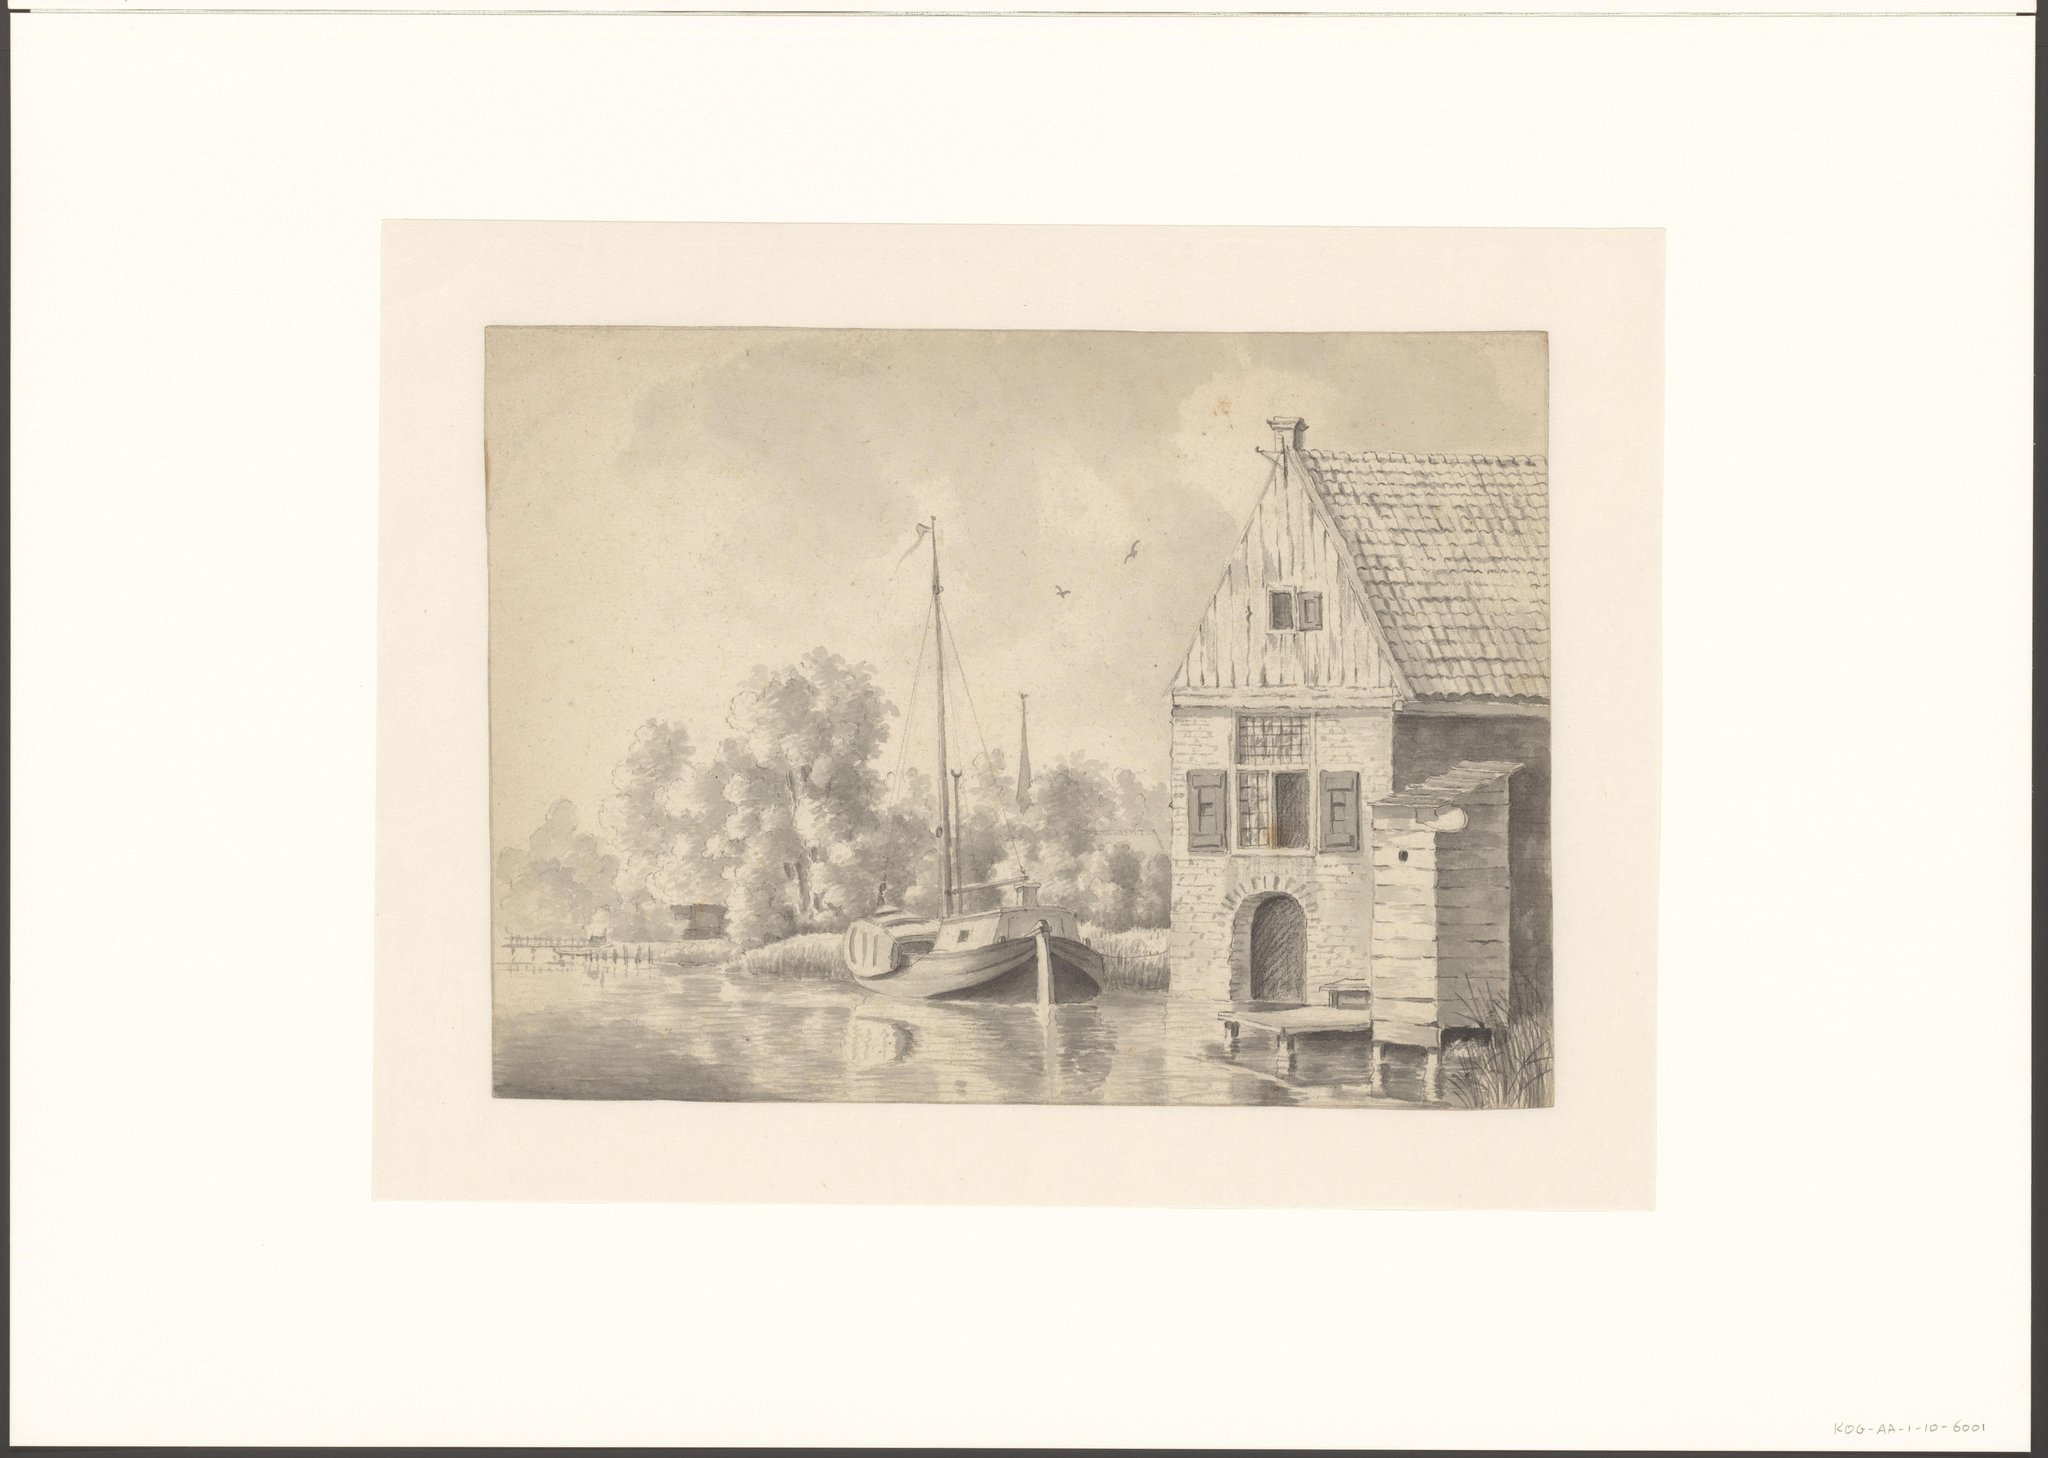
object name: drawing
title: Gezicht op de Overtoom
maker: evert doublet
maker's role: draughtsman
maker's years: 1802-1859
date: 1839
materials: chalk, ink, paper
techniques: brush, pen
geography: amsterdam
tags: sailing-ship, sailing-boat, city-view in general; 'veduta', canal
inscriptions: inscription: ‘de overtoom / 1839 / E DPZ / E Doublet.’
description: Onderwerpsrubriek binnen de Atlas Amsterdam: Overtoom.